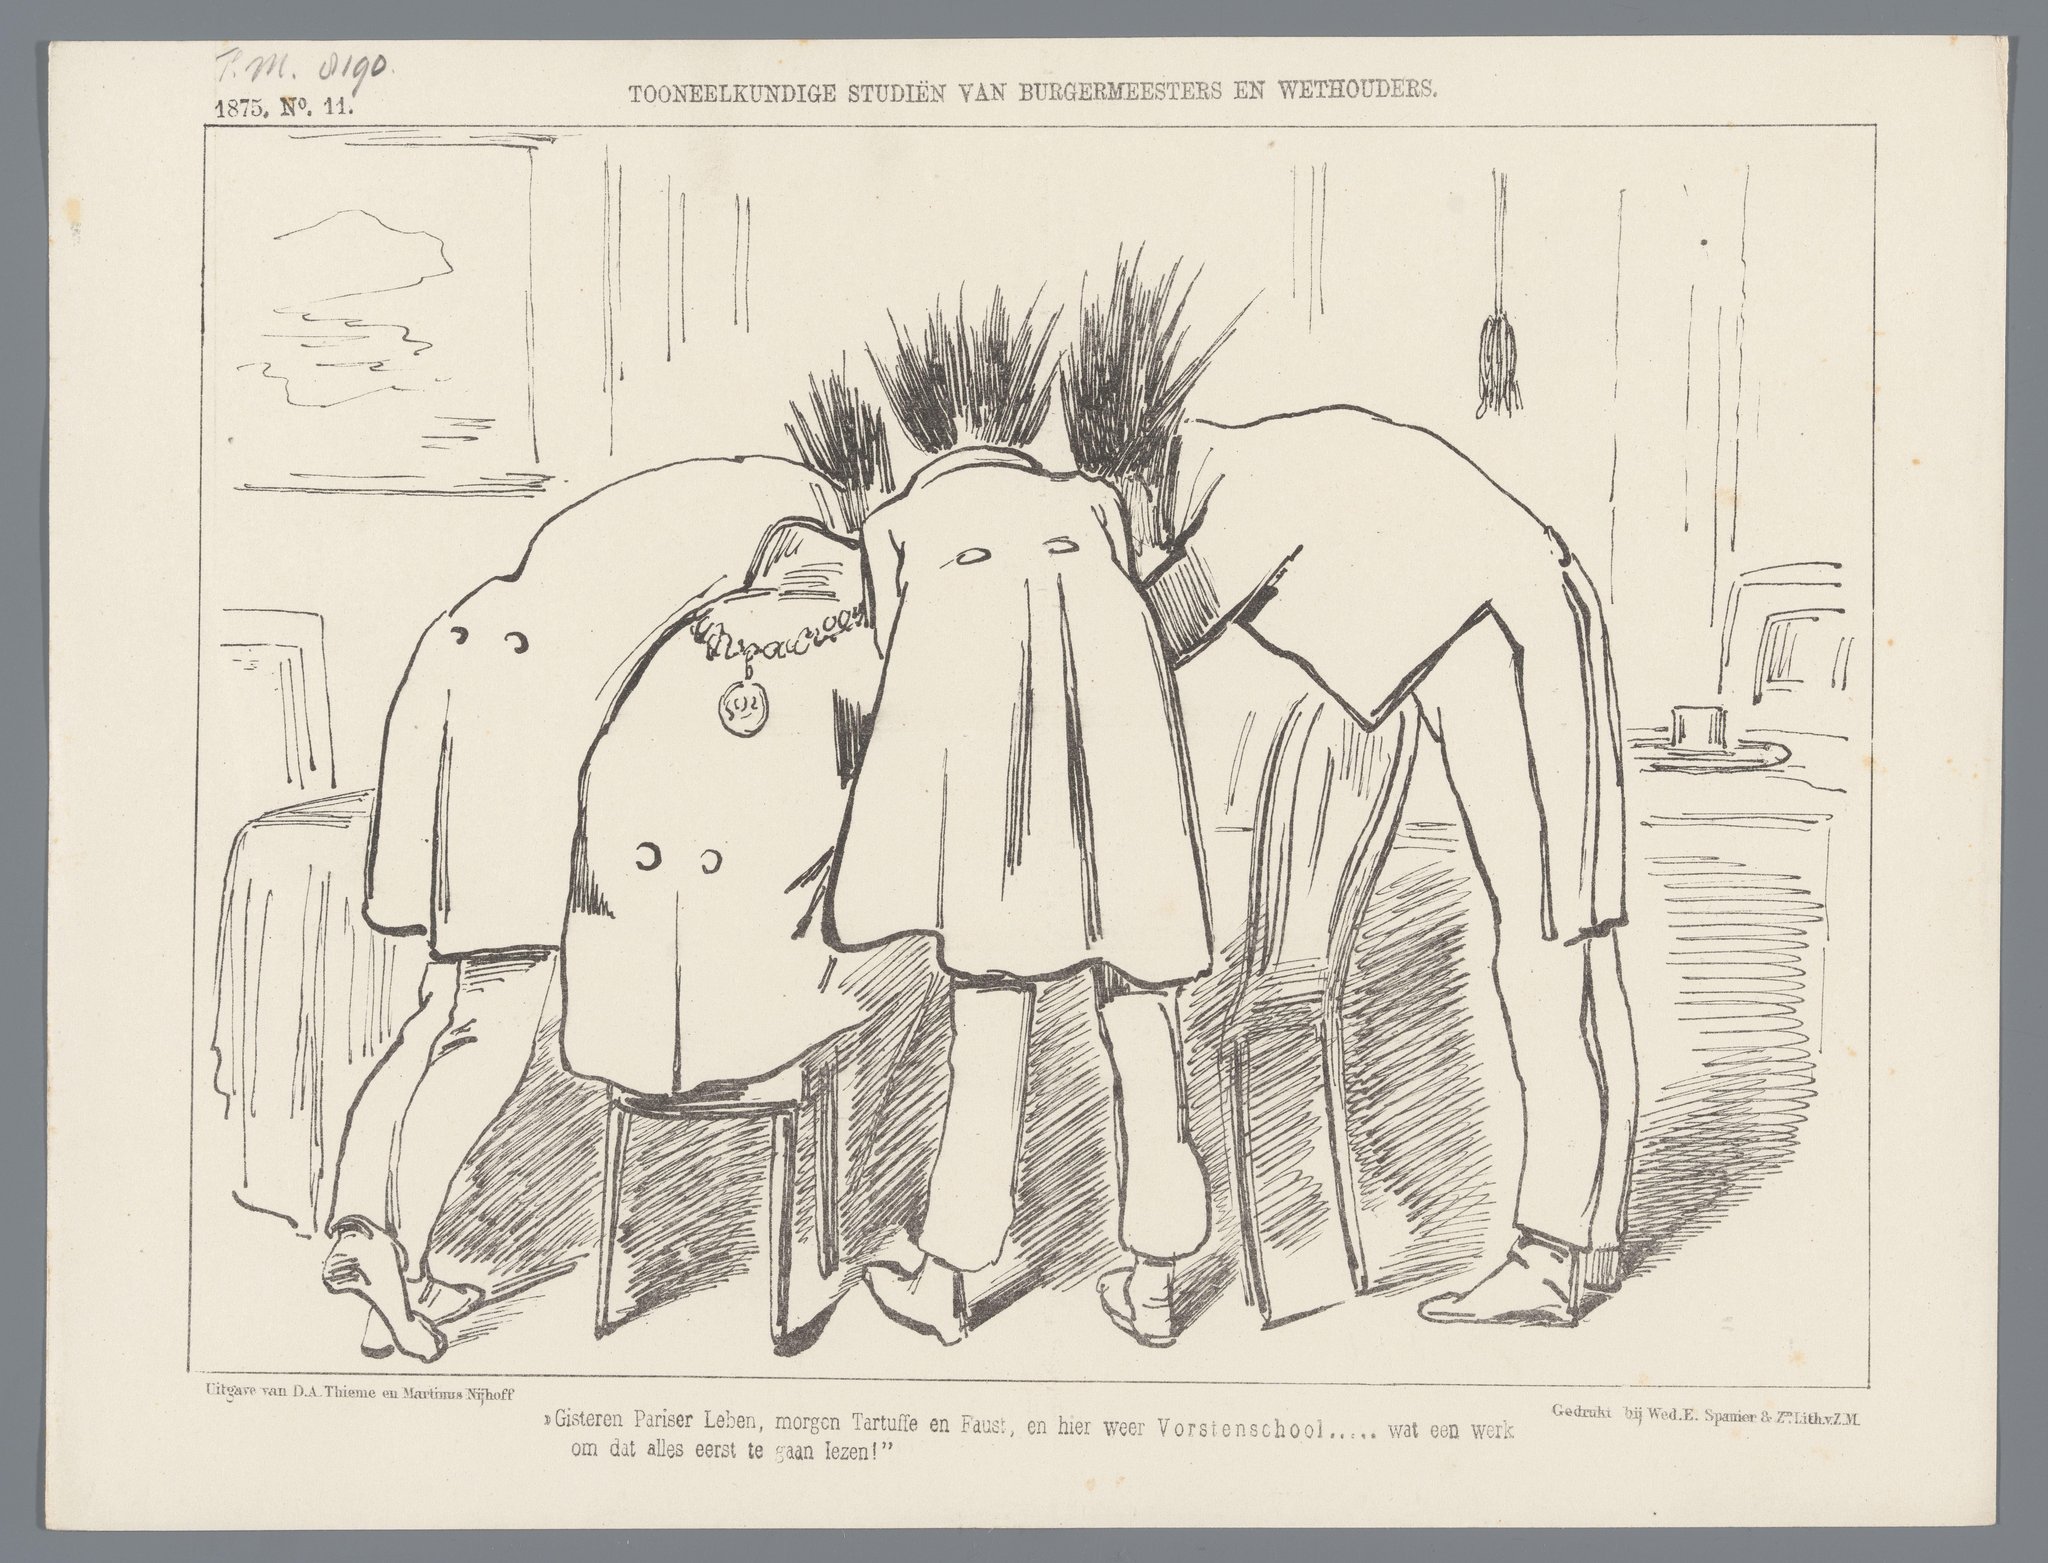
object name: print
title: Tooneelkundige studiën van burgermeesters en wethouders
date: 1875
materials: paper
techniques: lithograph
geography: netherlands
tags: den bosch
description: Spotprent naar aanleiding van het verbod van de waarnemende burgemeester van Den Bosch om aldaar het toneelstuk 'Pariser Leben' te spelen. Plaat verschenen bij het weekblad De Nederlandsche Spectator, nr. 11, 1875.